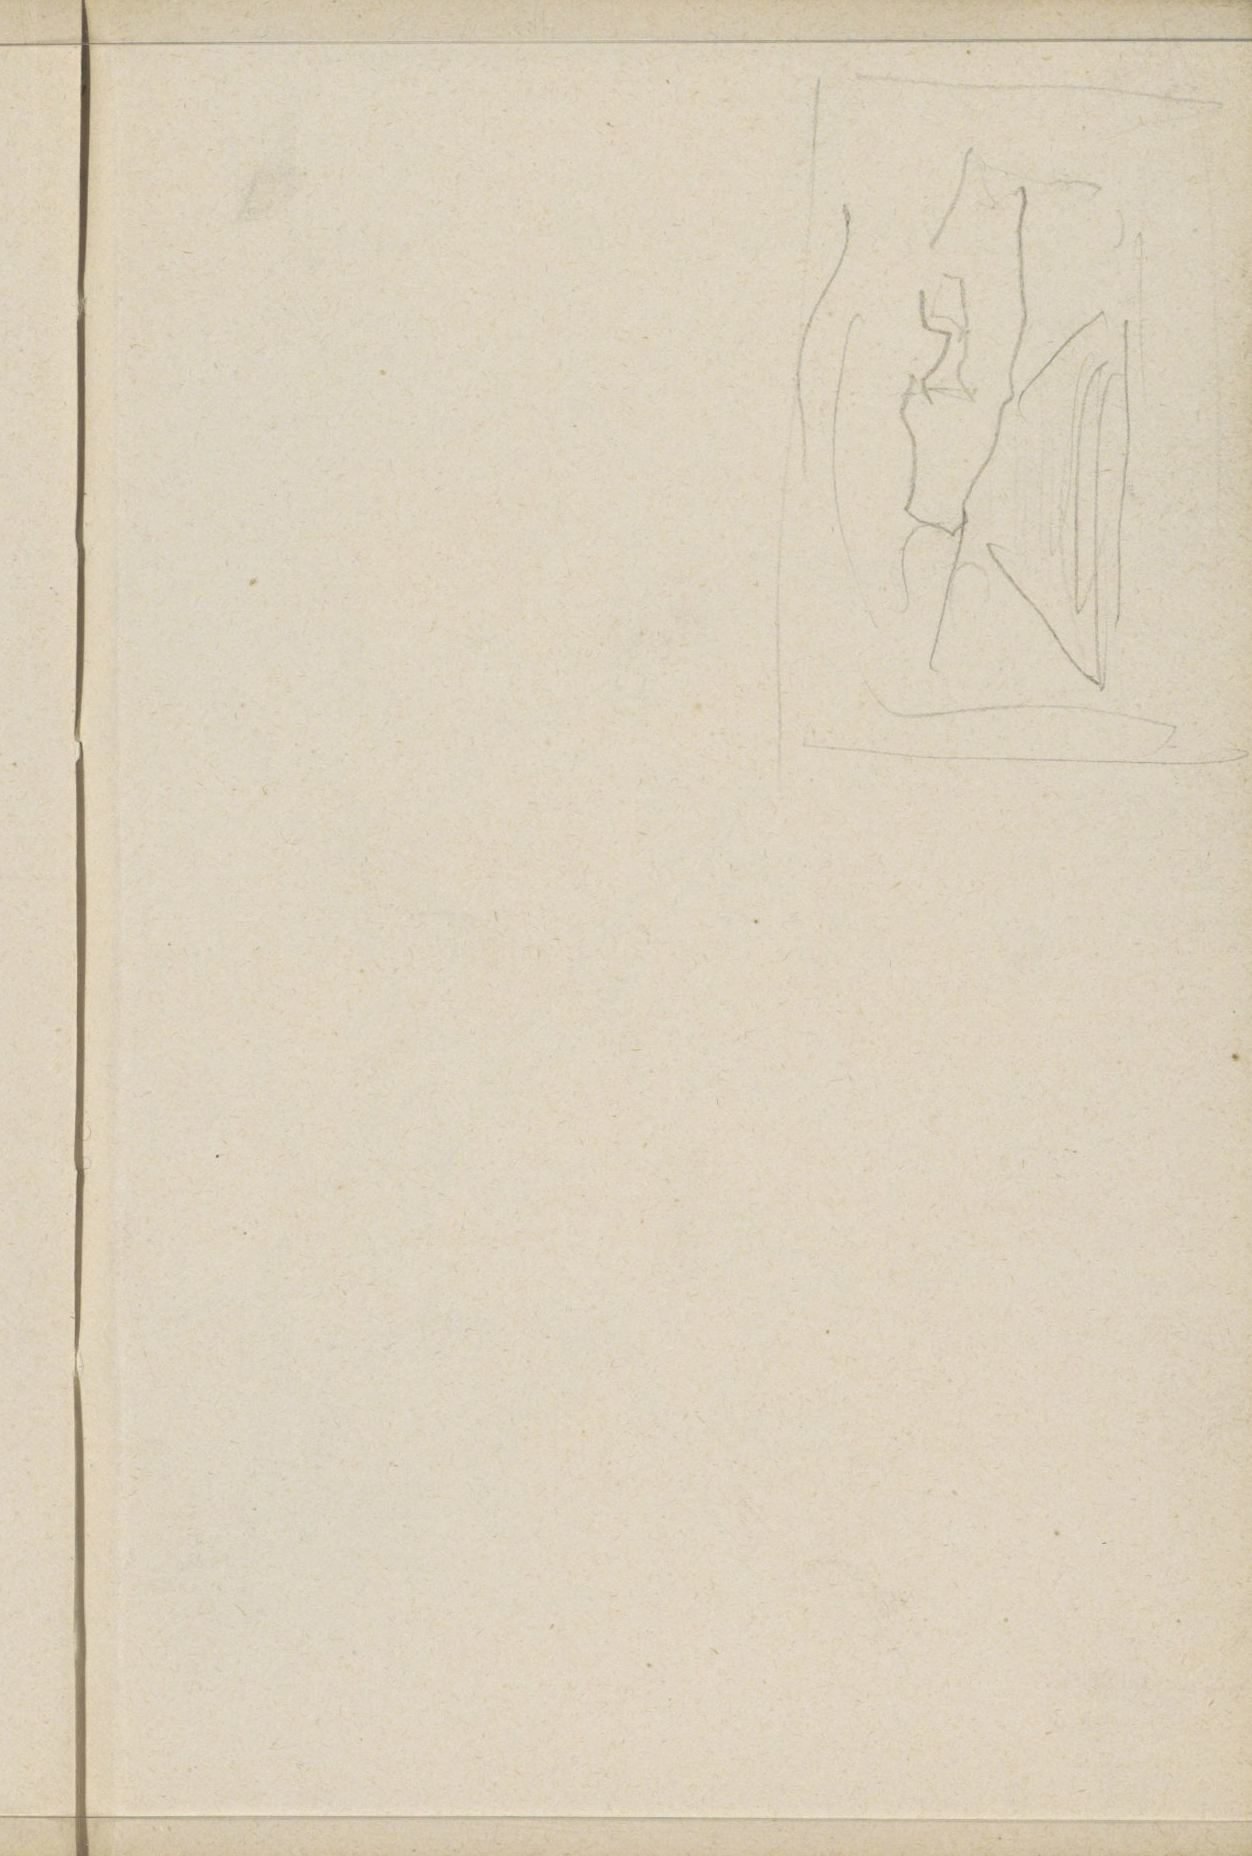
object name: sketchbook leaf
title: Studies, mogelijk een compositiestudie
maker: george hendrik breitner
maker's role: draughtsman, painter, print maker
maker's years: 1857-1923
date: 1909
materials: paper, pencil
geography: amsterdam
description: Studie, mogelijk een compositiestudie. Pagina 88 uit een schetsboek met 45 bladen vervaardigd in Amsterdam en Pittsburgh.